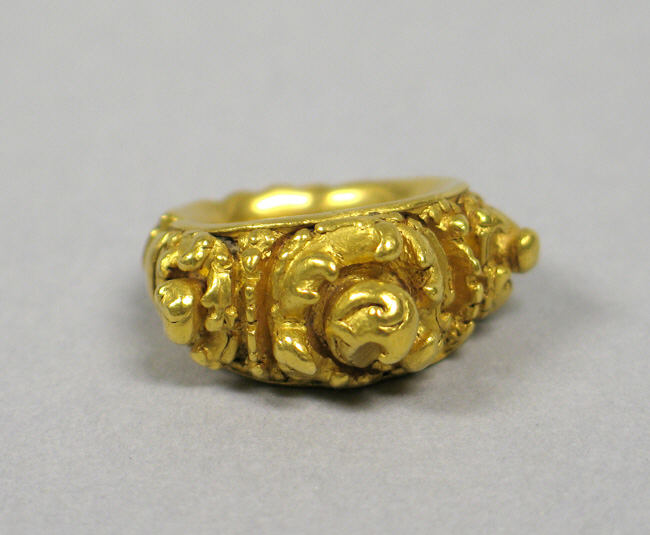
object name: ear ornament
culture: indonesian, javanese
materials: gold